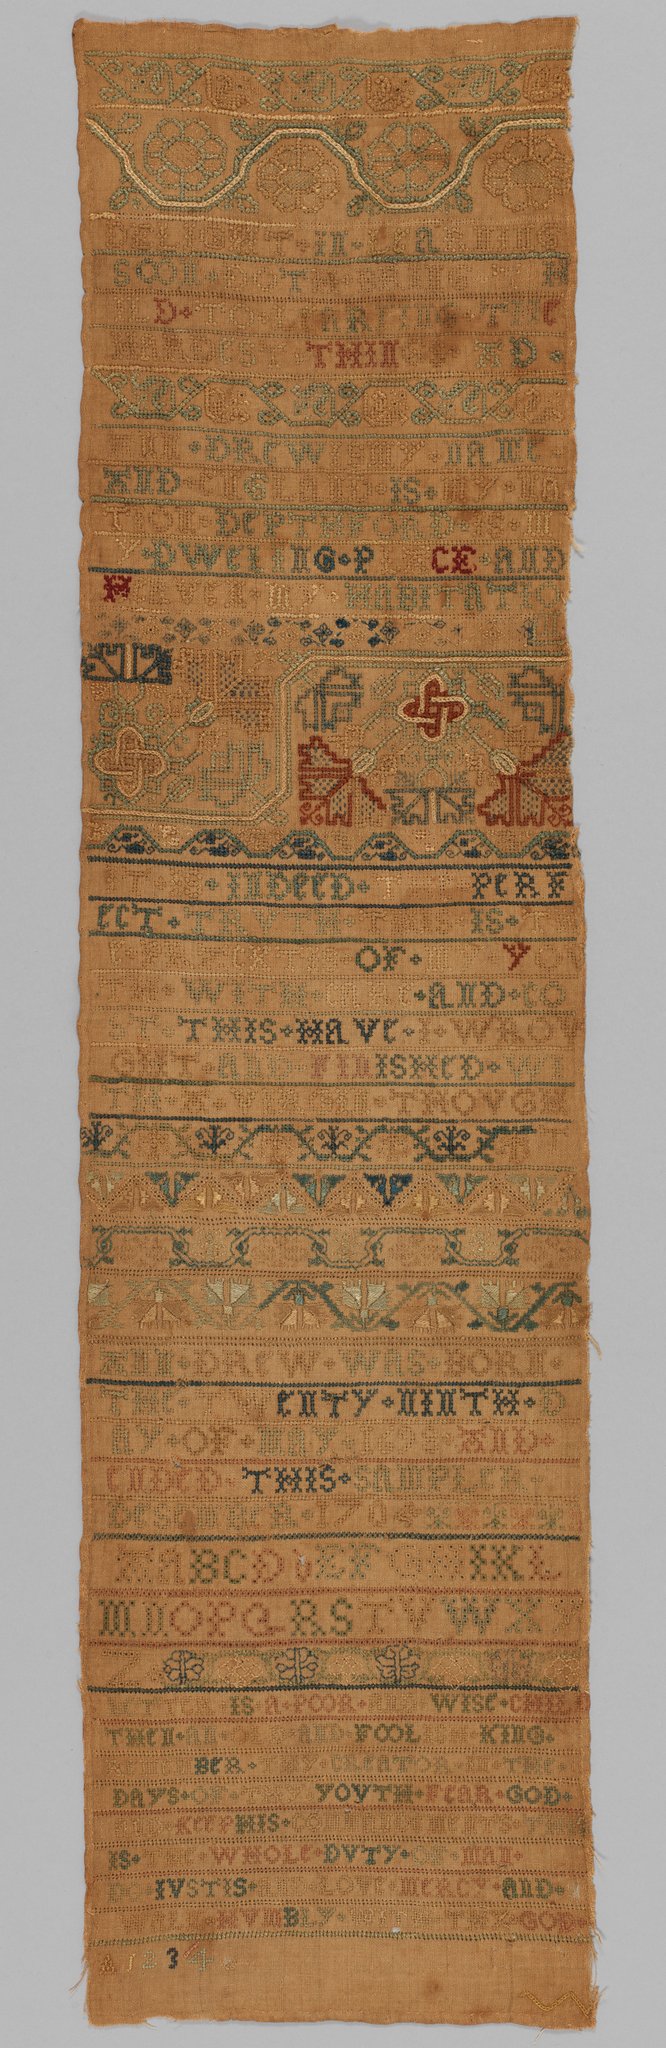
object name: sampler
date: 1704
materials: linen, silk